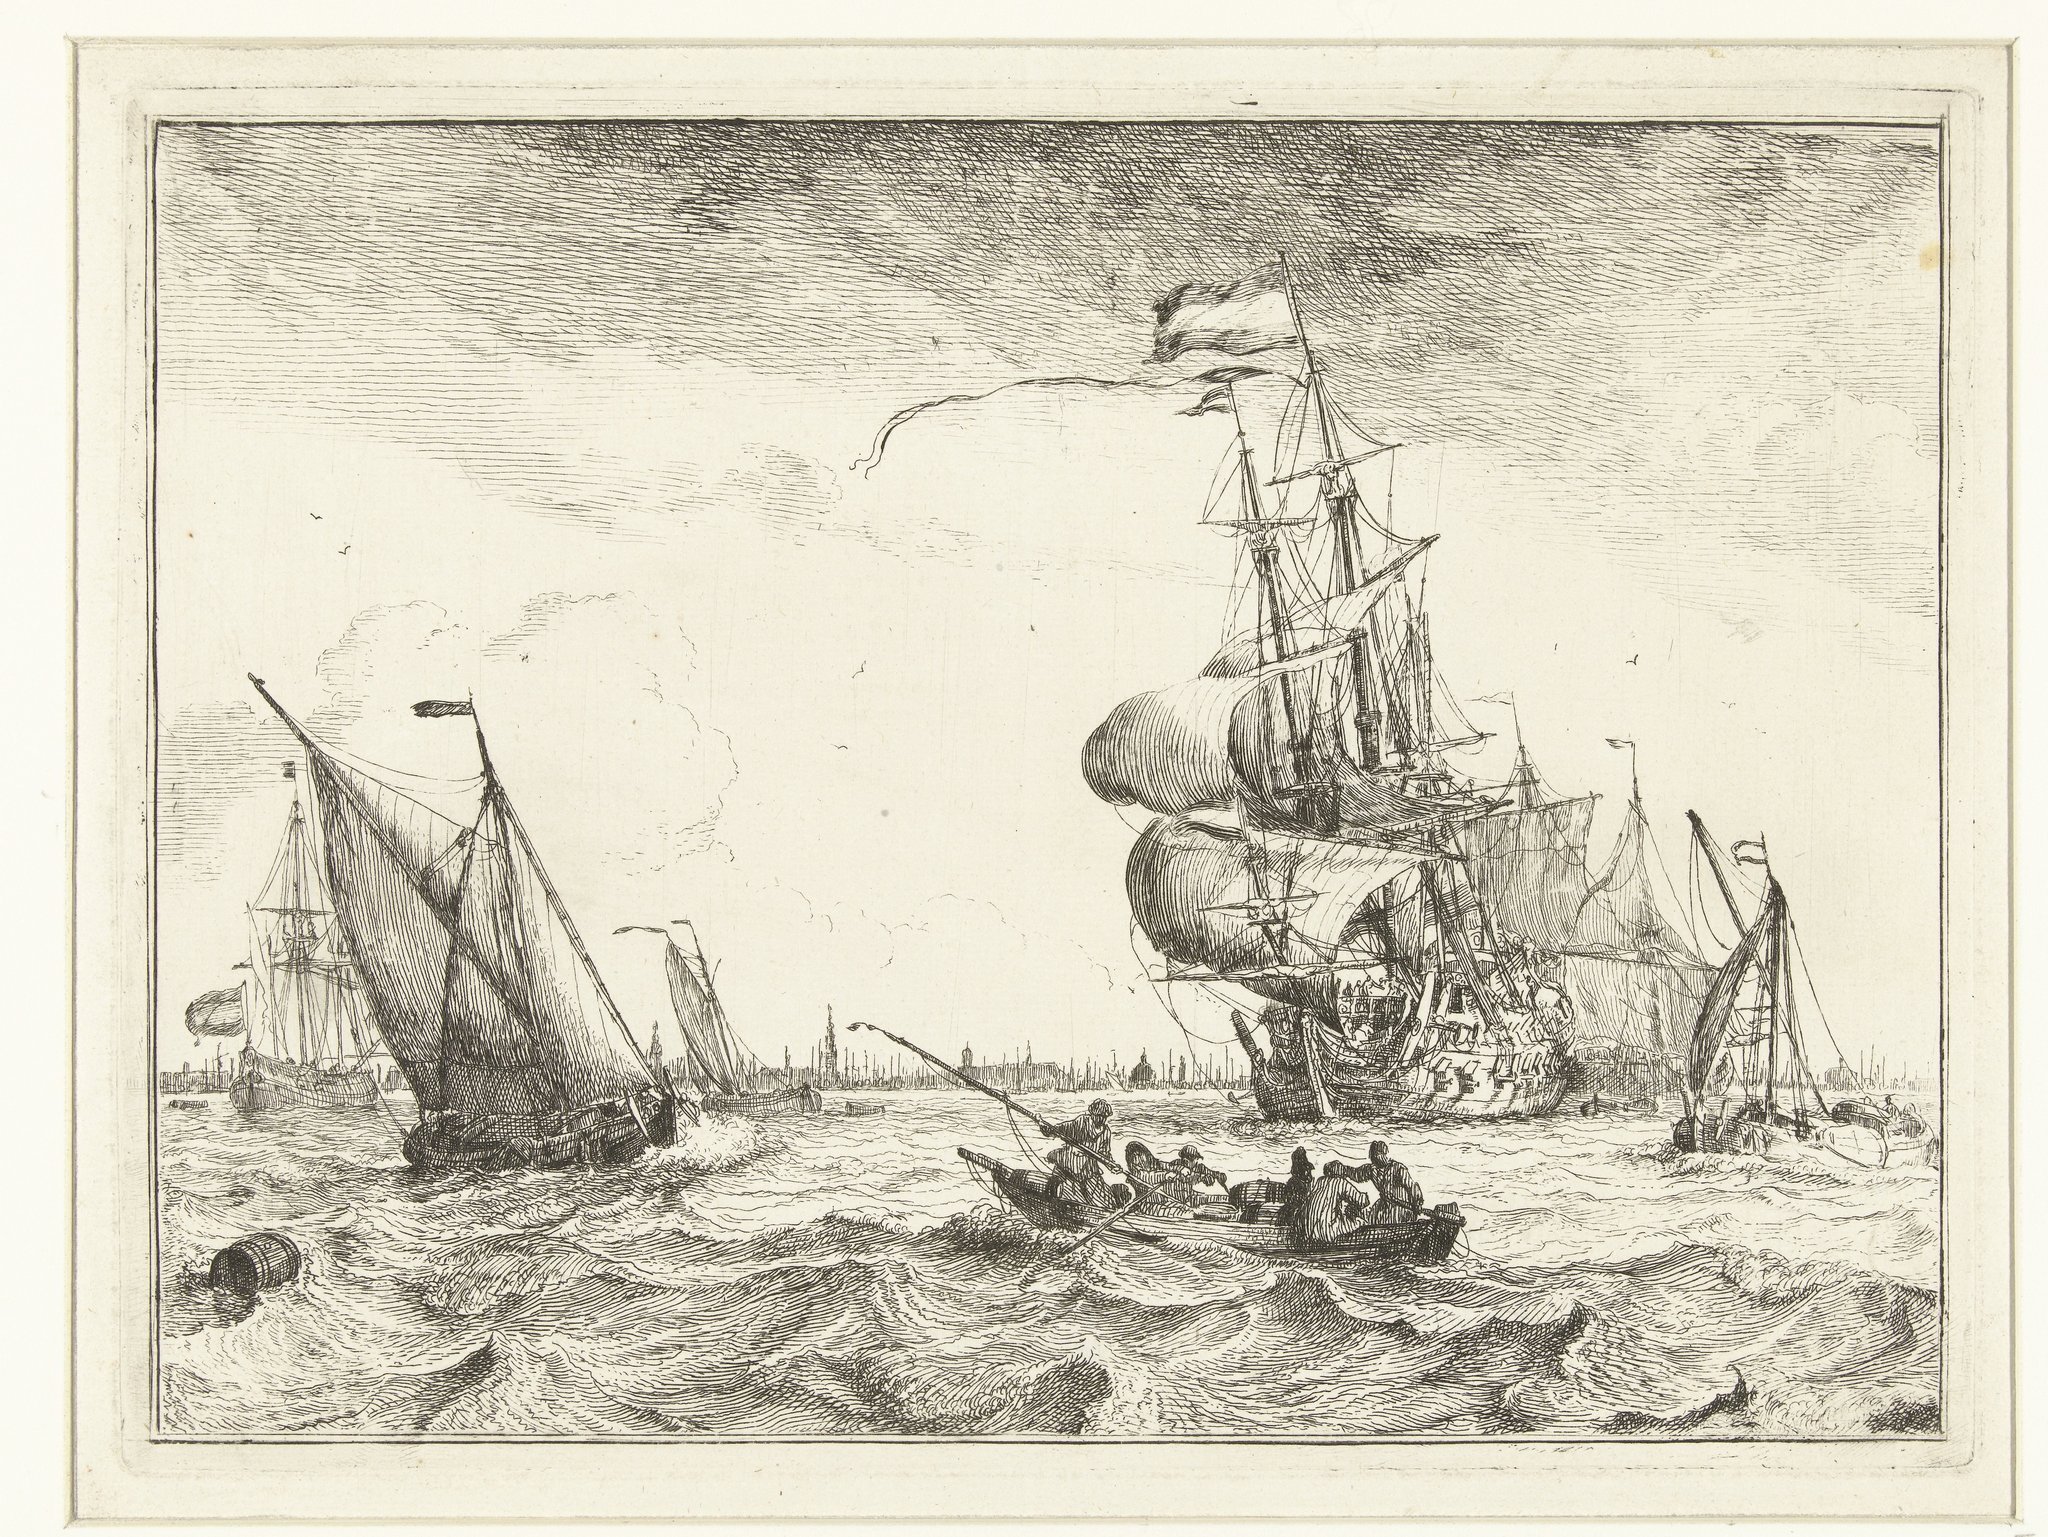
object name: print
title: Gezicht op het IJ met roeiboot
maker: ludolf bakhuysen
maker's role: draughtsman, print maker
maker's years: 1631-1708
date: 1701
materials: paper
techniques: etching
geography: amsterdam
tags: sea (seascape)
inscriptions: collector's mark: Lugt 2166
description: Gezicht op het IJ in Amsterdam. Op de voorgrond een roeiboot met zes mannen, op de achtergrond grotere schepen. Prent uit een serie met tien zeegezichten.